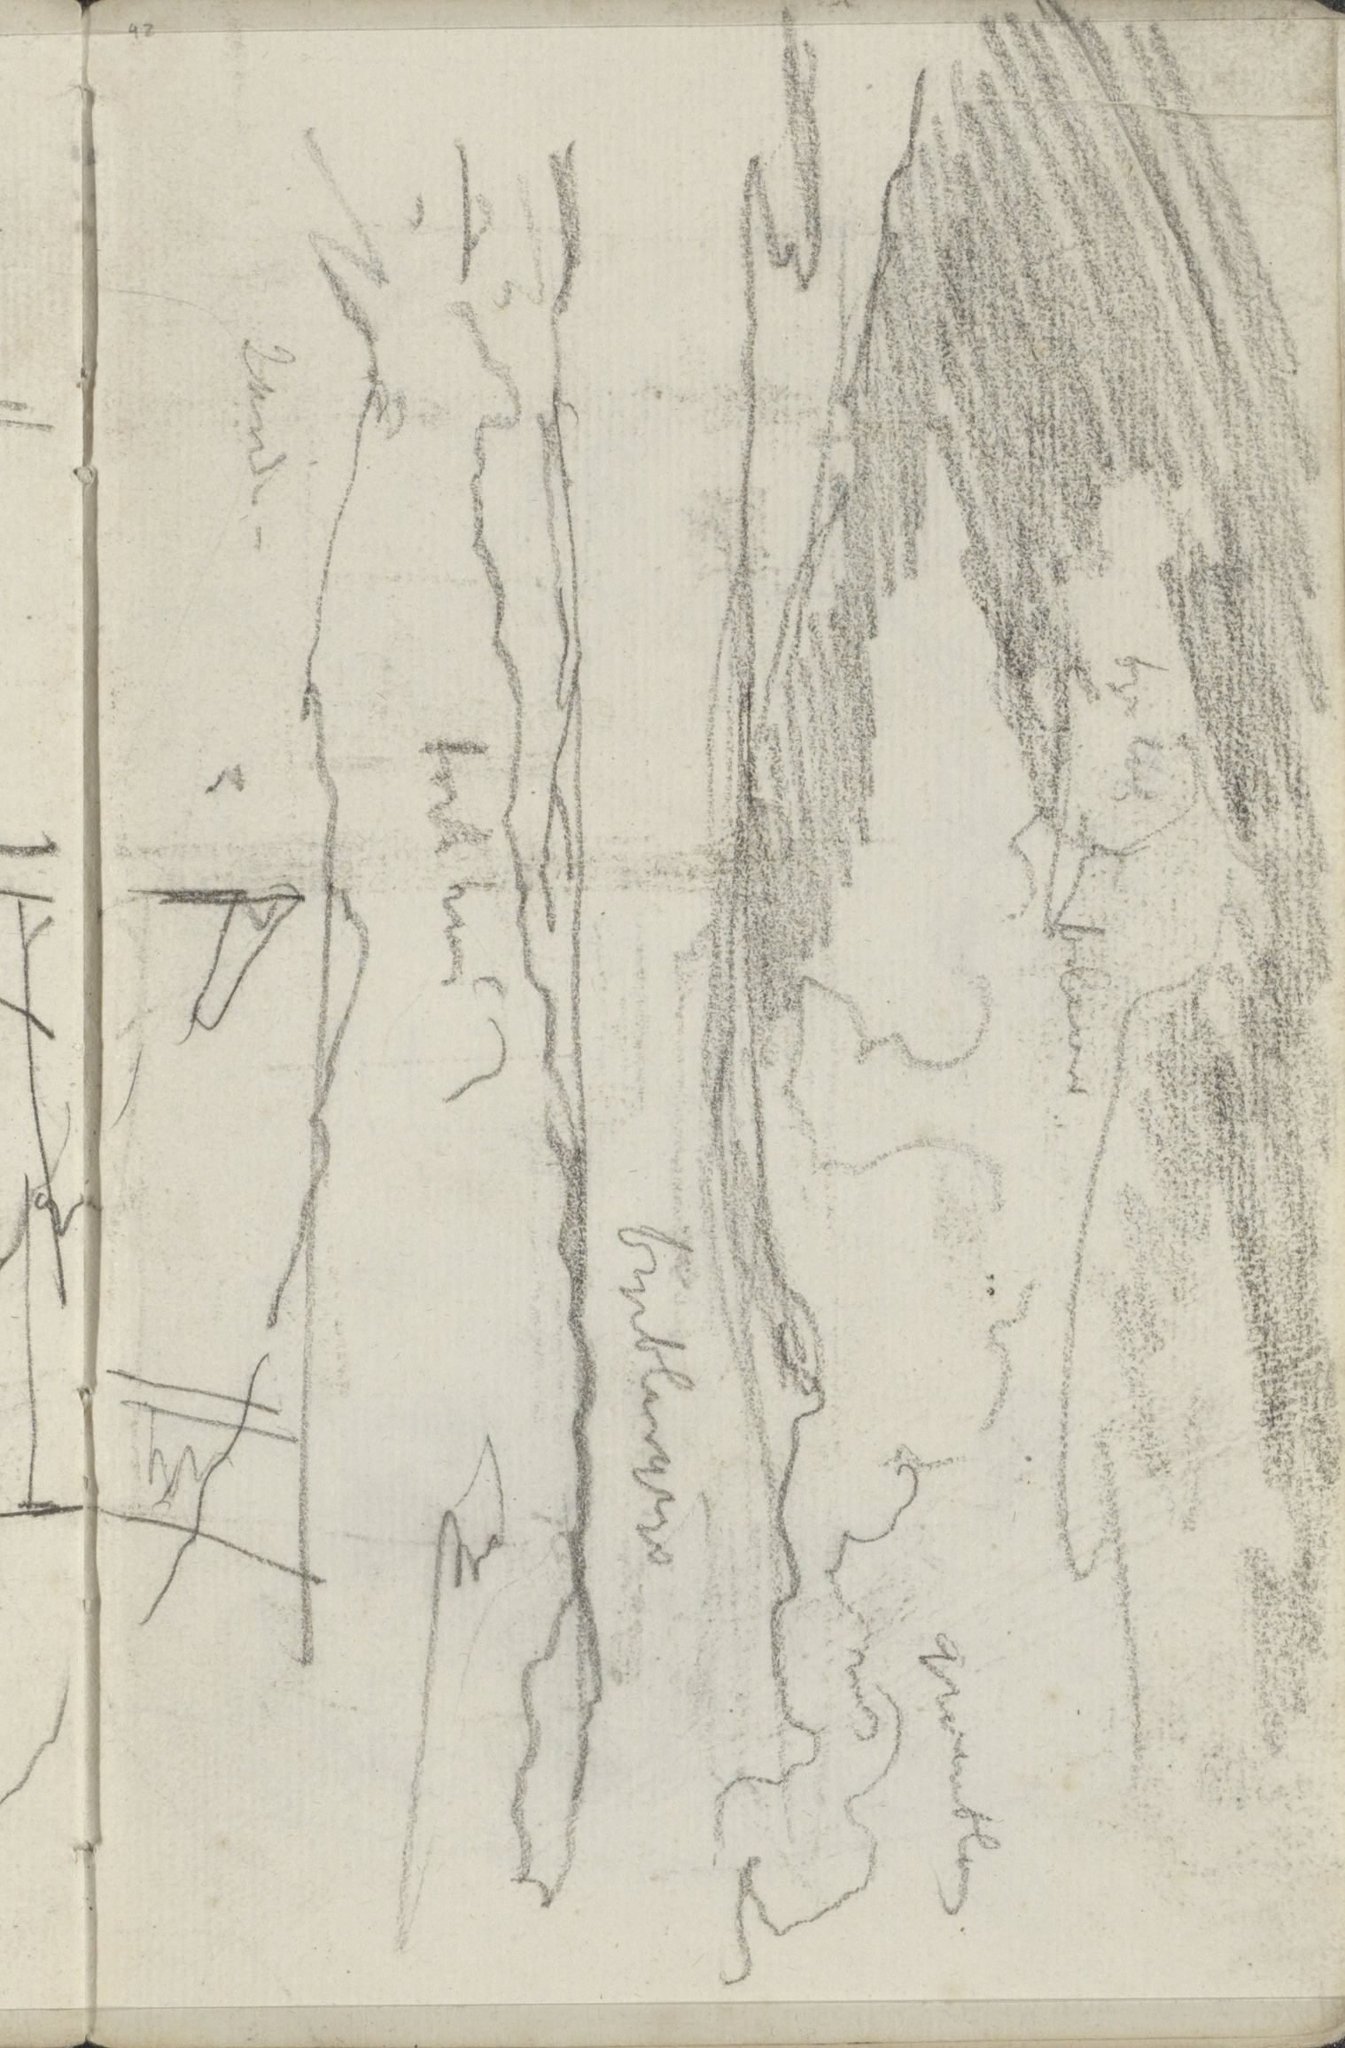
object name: sketchbook leaf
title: Landschap met wolkenlucht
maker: george hendrik breitner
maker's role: draughtsman, painter, print maker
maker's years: 1857-1923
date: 1880-1882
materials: chalk, paper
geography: the hague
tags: landscapes, clouds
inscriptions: kleurnotitie, handgeschreven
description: Pagina 42 uit een schetsboek met 23 bladen.